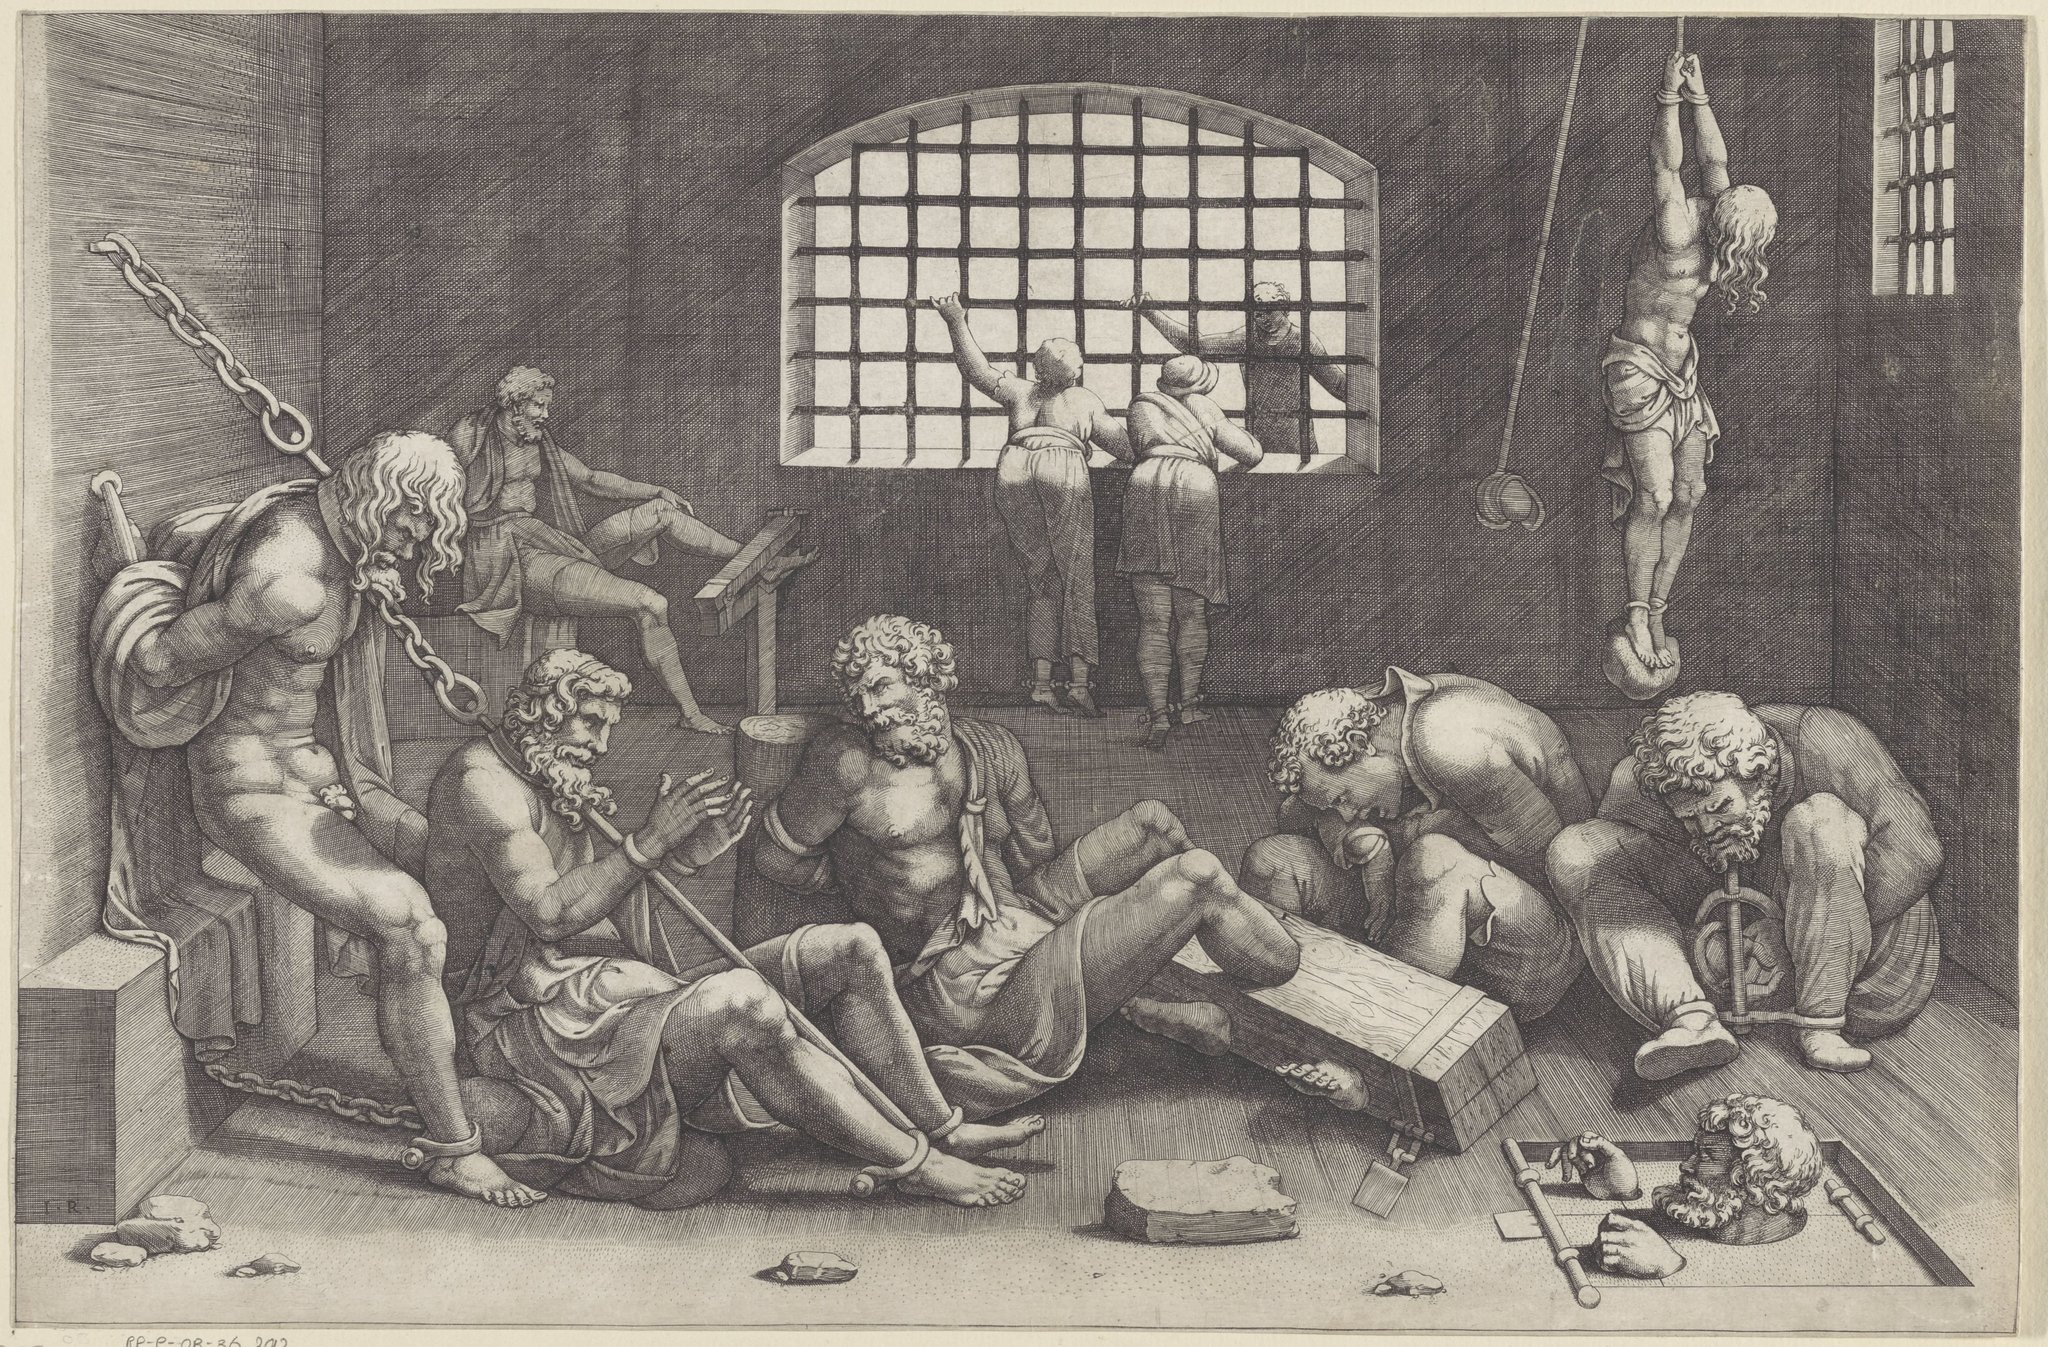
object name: print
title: Gevangenis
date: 1530-1582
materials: paper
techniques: engraving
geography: italy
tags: prison, jail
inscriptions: collector's mark: Lugt 240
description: Zicht in een gevangeniscel met tien gevangenen. De gevangenen zijn op verschillende manieren geketend.